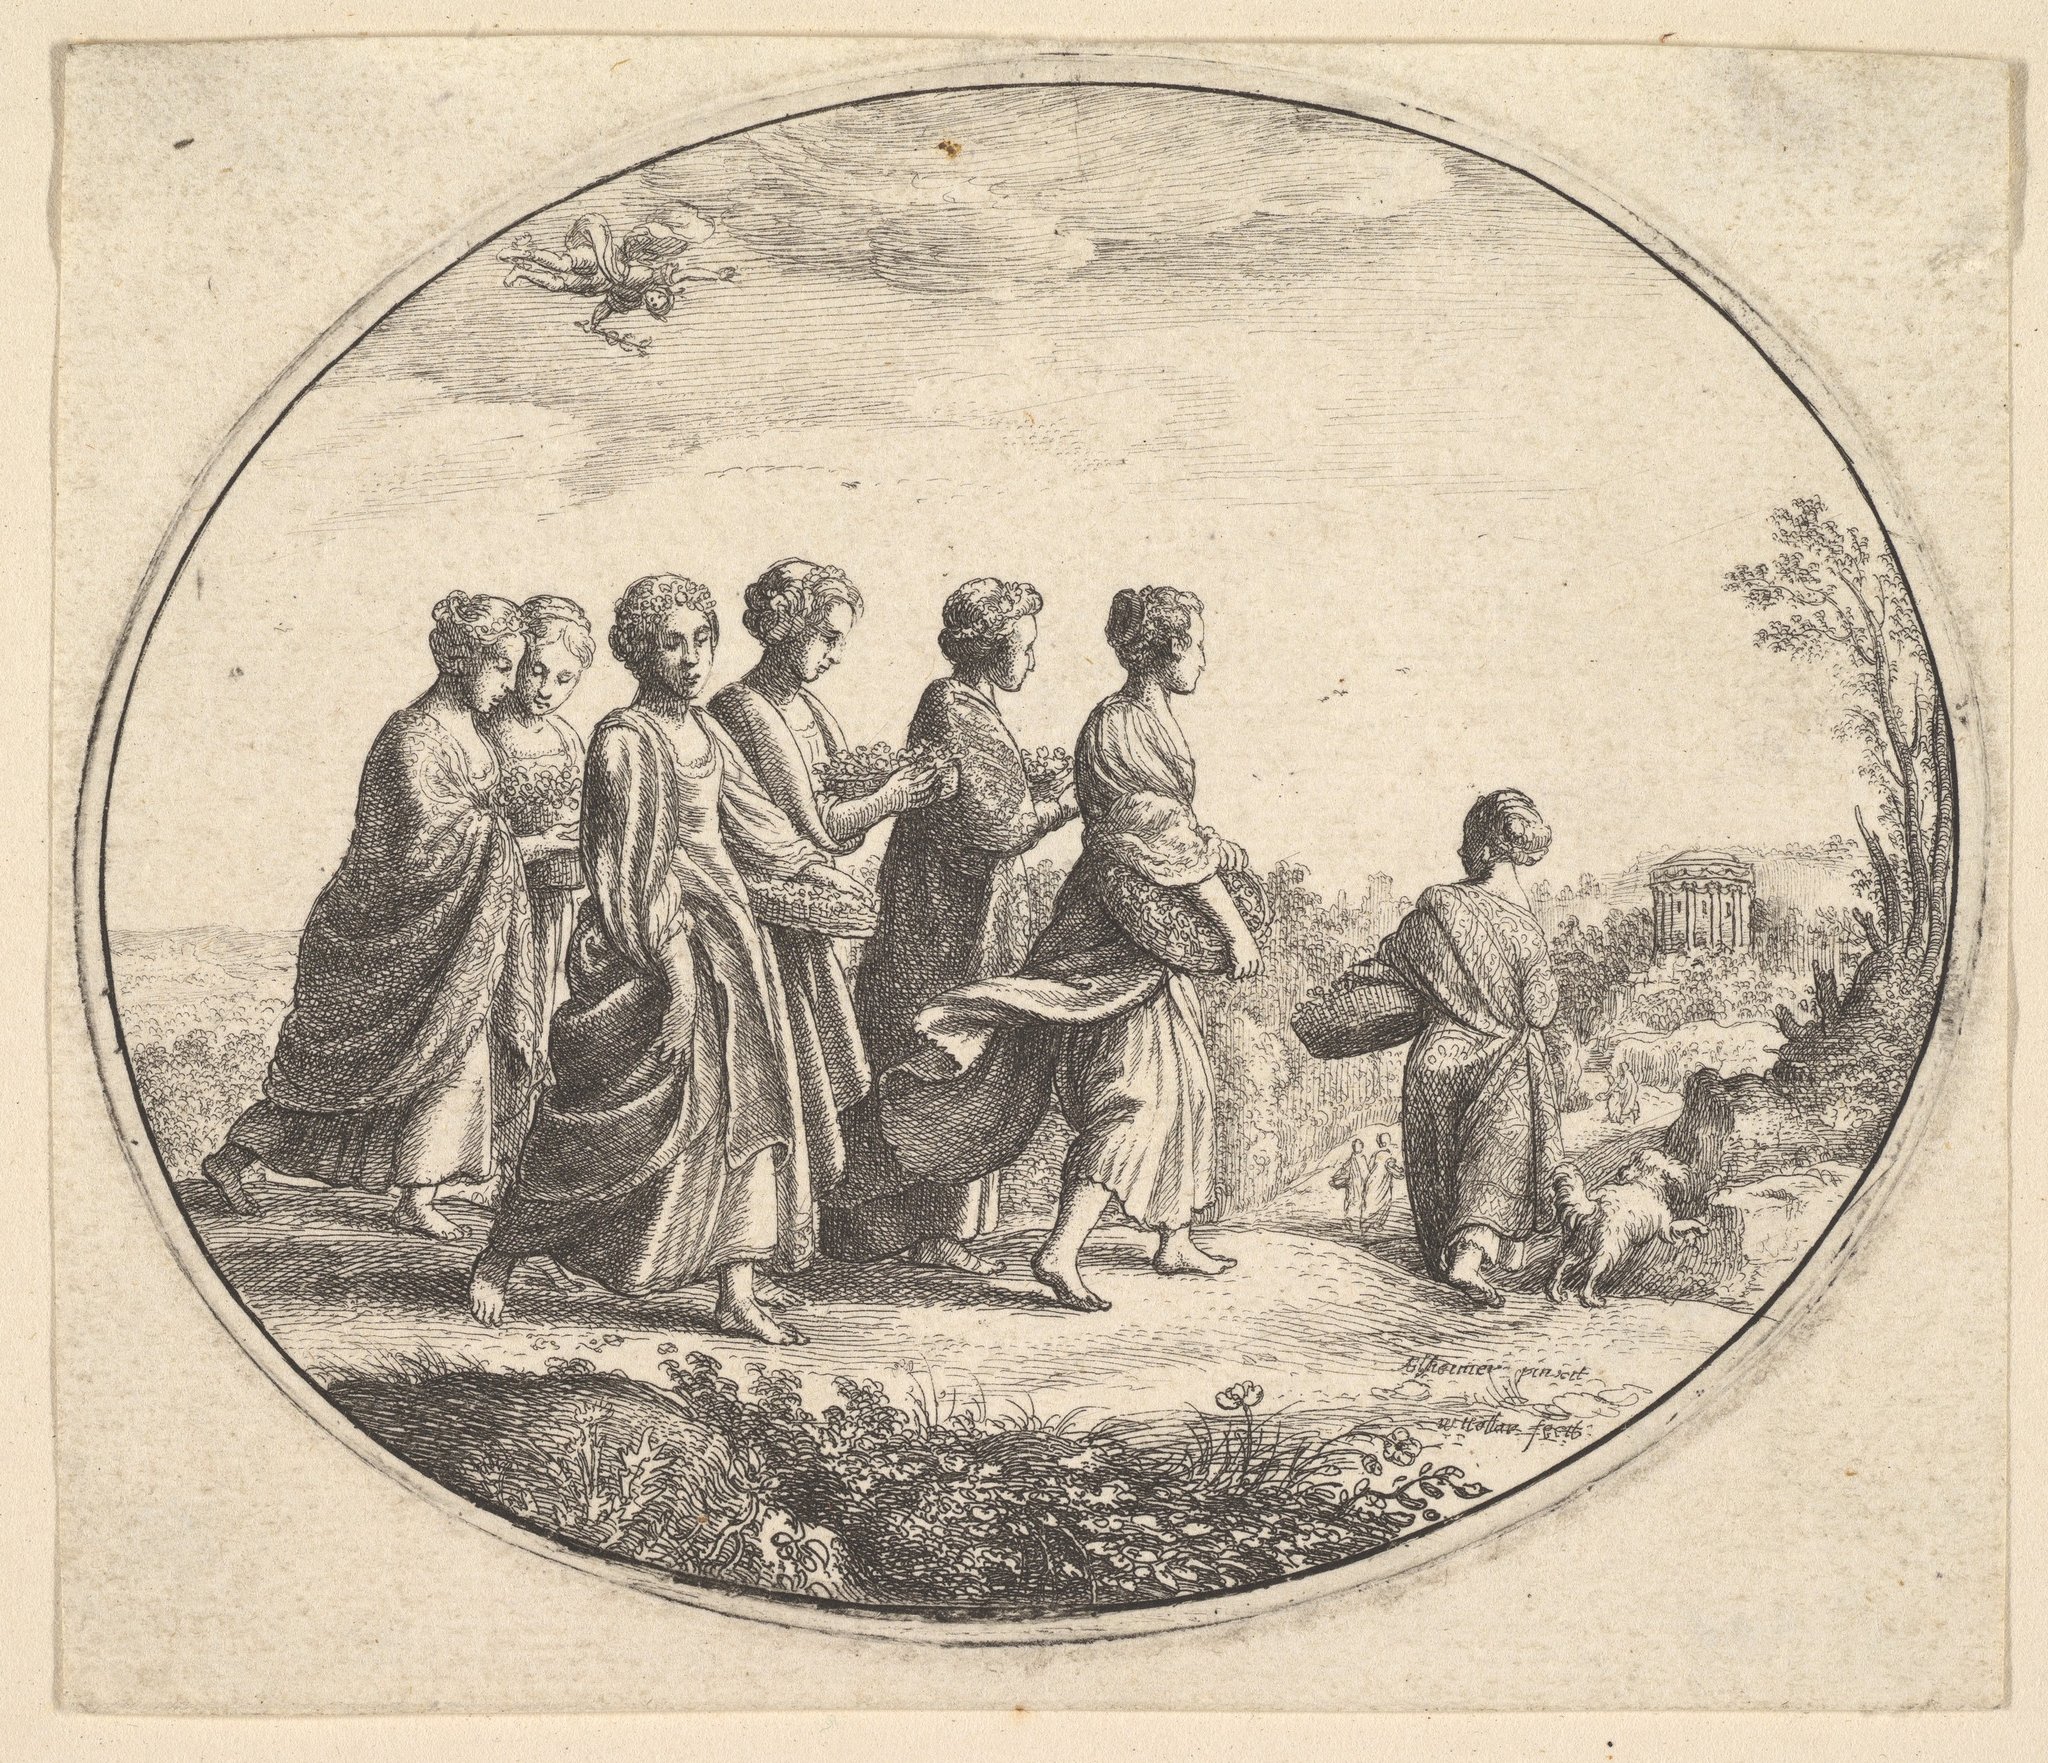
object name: print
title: The daughters of Aglaura (Mercury and Herse)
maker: wenceslaus hollar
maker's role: artist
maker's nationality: bohemian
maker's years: 1607-1677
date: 1646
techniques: etching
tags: women,dogs